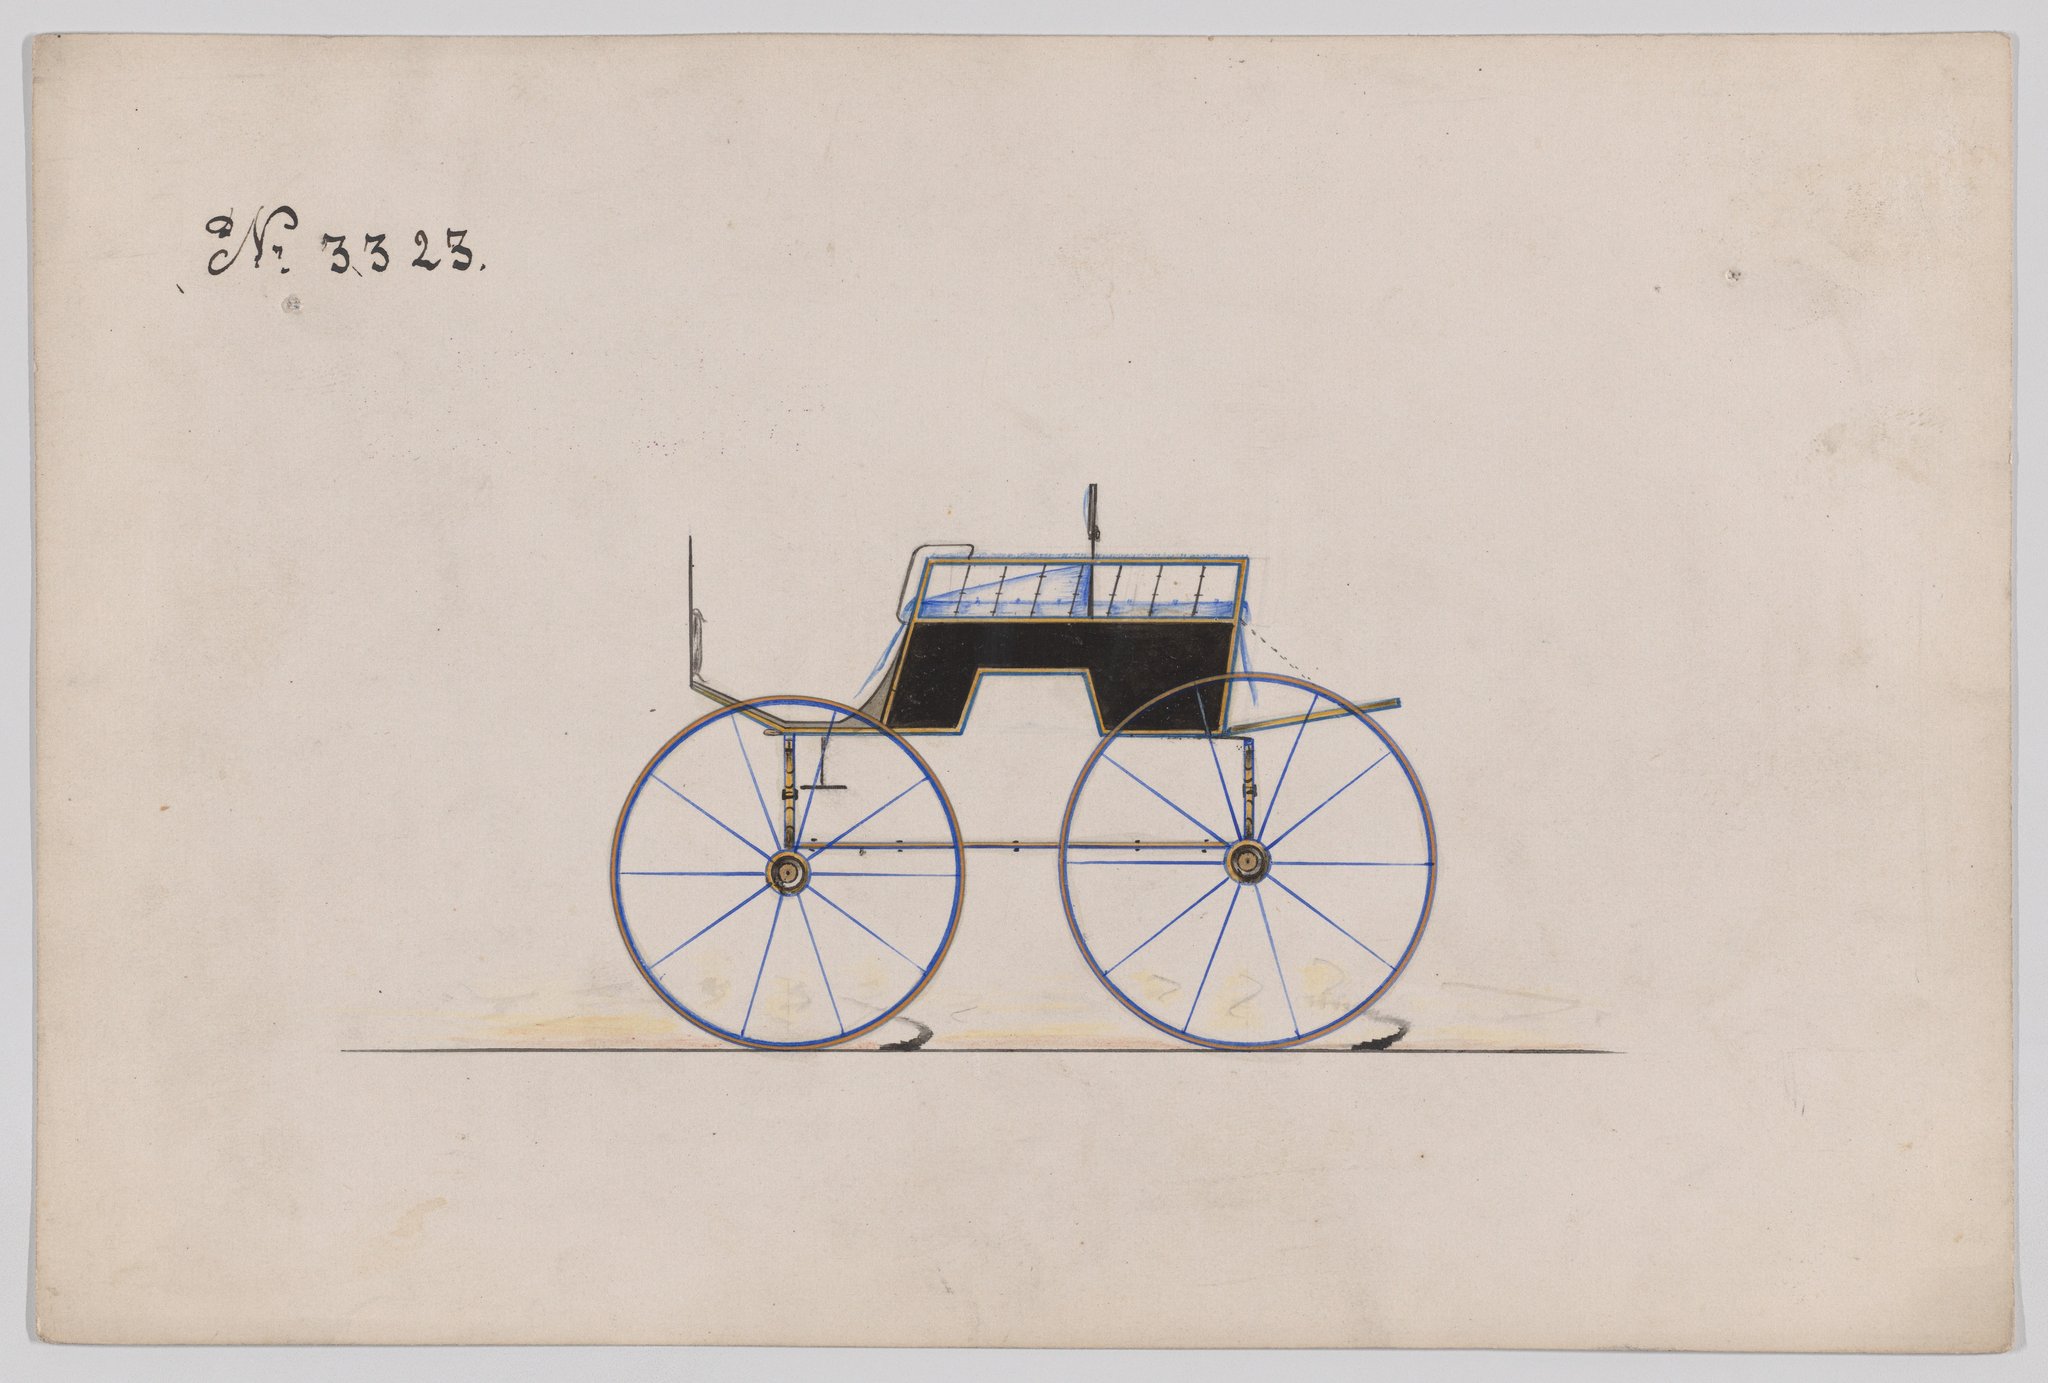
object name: drawing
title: Game Wagon # 3323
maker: brewster & co.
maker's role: manufacturer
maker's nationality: american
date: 1877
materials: gum arabic, ink, watercolor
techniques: pen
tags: carriages